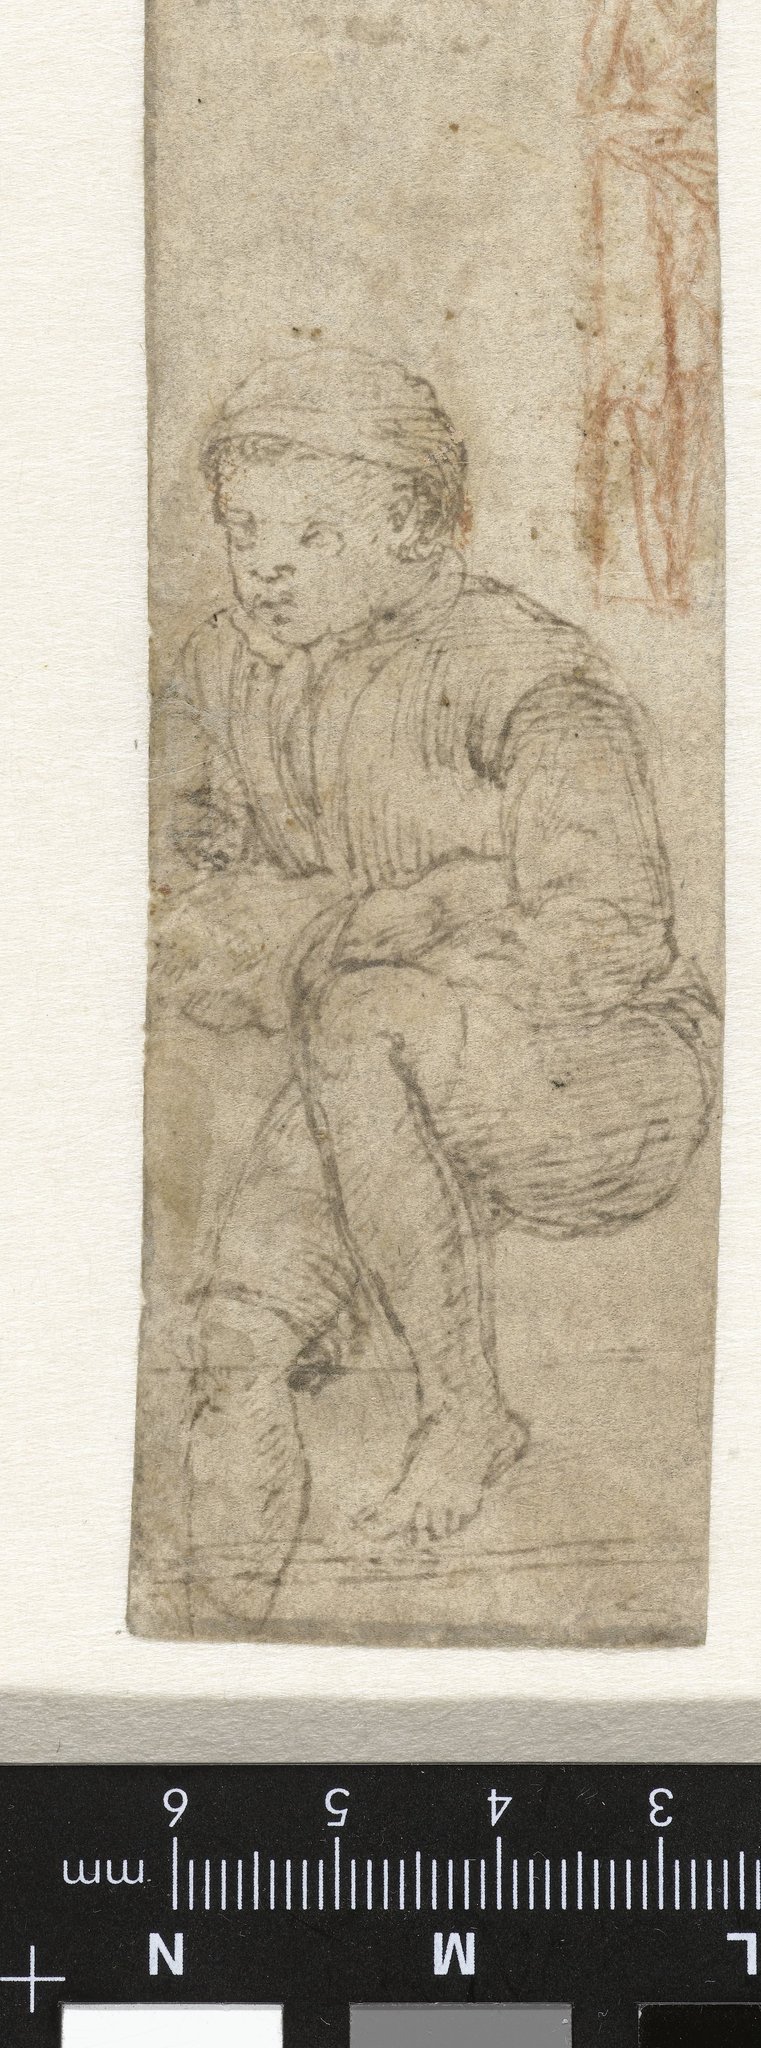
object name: drawing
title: Zittende jongen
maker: francesco granacci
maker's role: draughtsman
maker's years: 1477-1543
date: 1480-1543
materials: chalk, ink, paper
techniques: pen